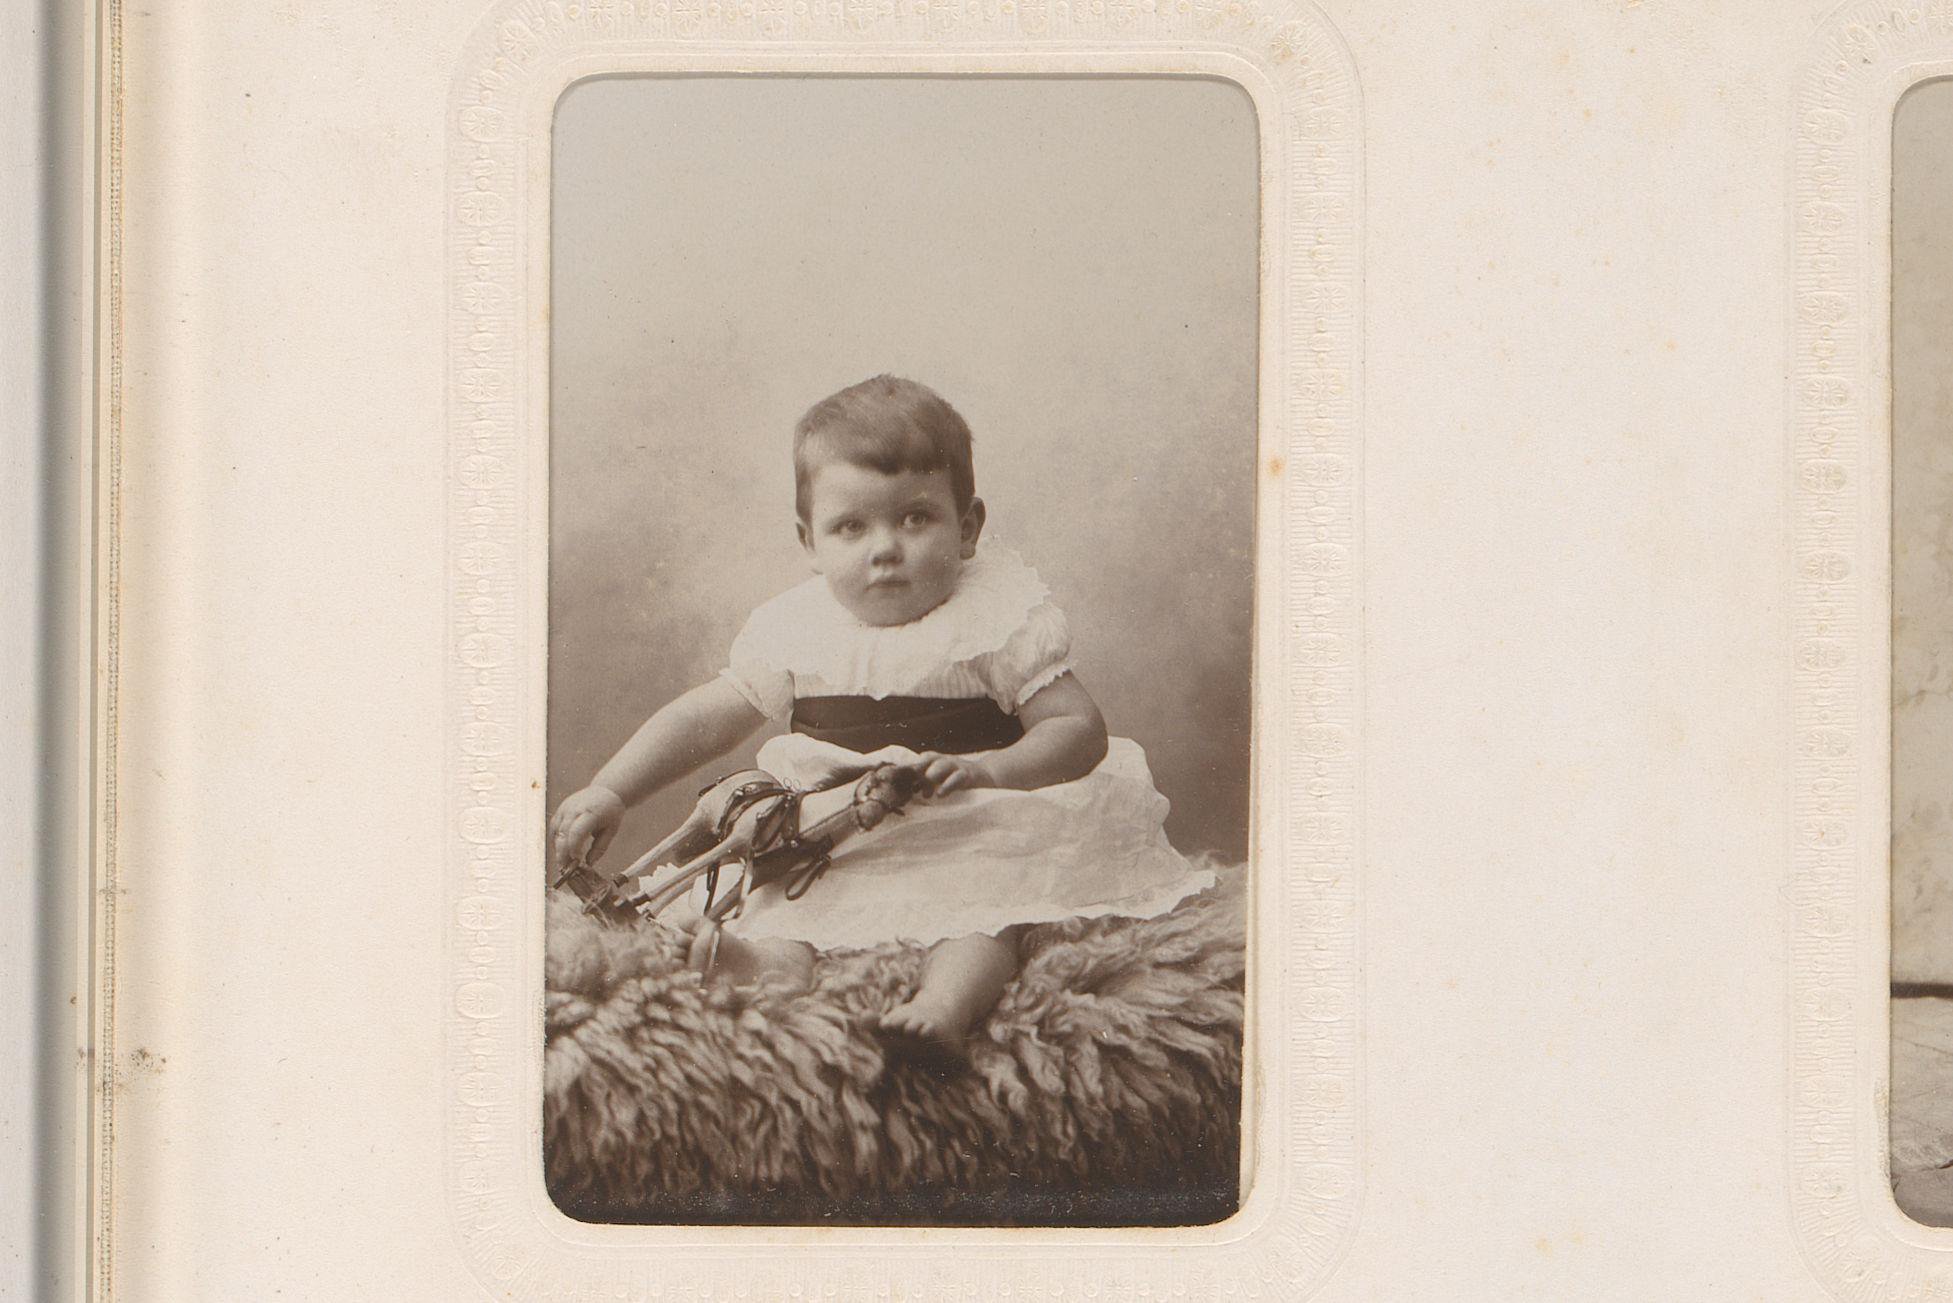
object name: album leaf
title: Portret van een jongen in kostuum met hoed met veer, leunend op een balustrade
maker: Anonymous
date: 1880-1920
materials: cardboard, photographic support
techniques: collodion silver print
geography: netherlands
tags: boy (child between toddler and youth), historical persons, head-gear: hat, balustrade